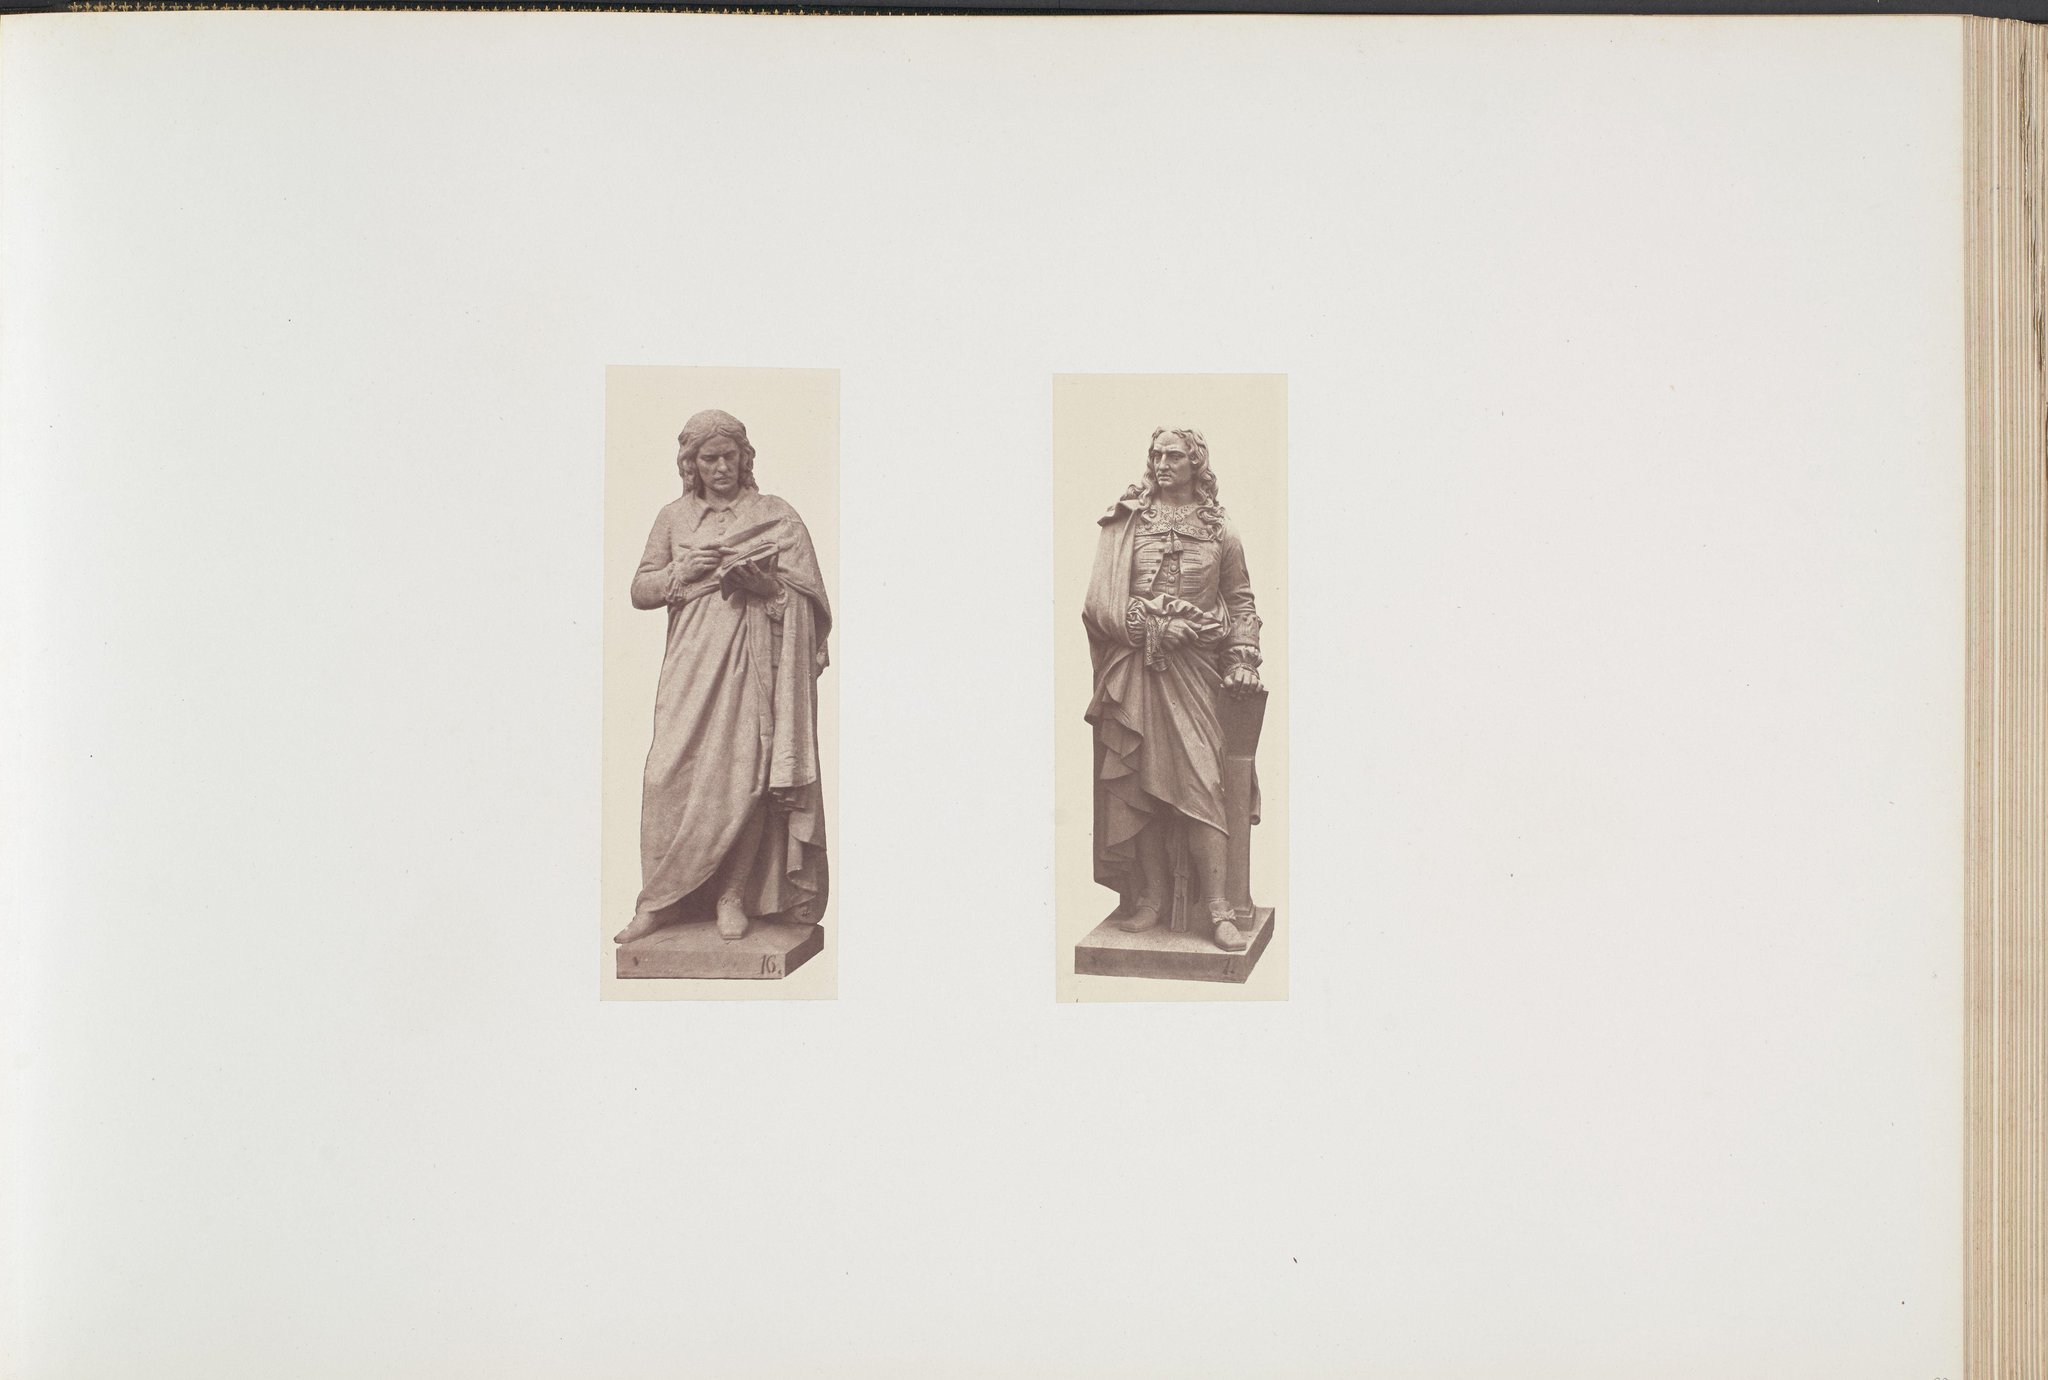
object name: photograph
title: Gipsmodellen voor beeldhouwwerken op het Palais du Louvre: links "Poussin" door François Rude en rechts "Audran" door Jacques Maillet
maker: édouard denis baldus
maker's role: fotograaf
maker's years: 1813-1889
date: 1855-1857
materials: paper, photographic support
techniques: salted paper print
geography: paris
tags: painter, draughtsman, nicolas poussin, piece of sculpture, reproduction of a piece of sculpture, permanent exhibition, museum, paris, tuileries palace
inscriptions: number: ‘16 en 71’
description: Onderdeel van Réunion des Tuileries au Louvre 1852-1857, album 2.